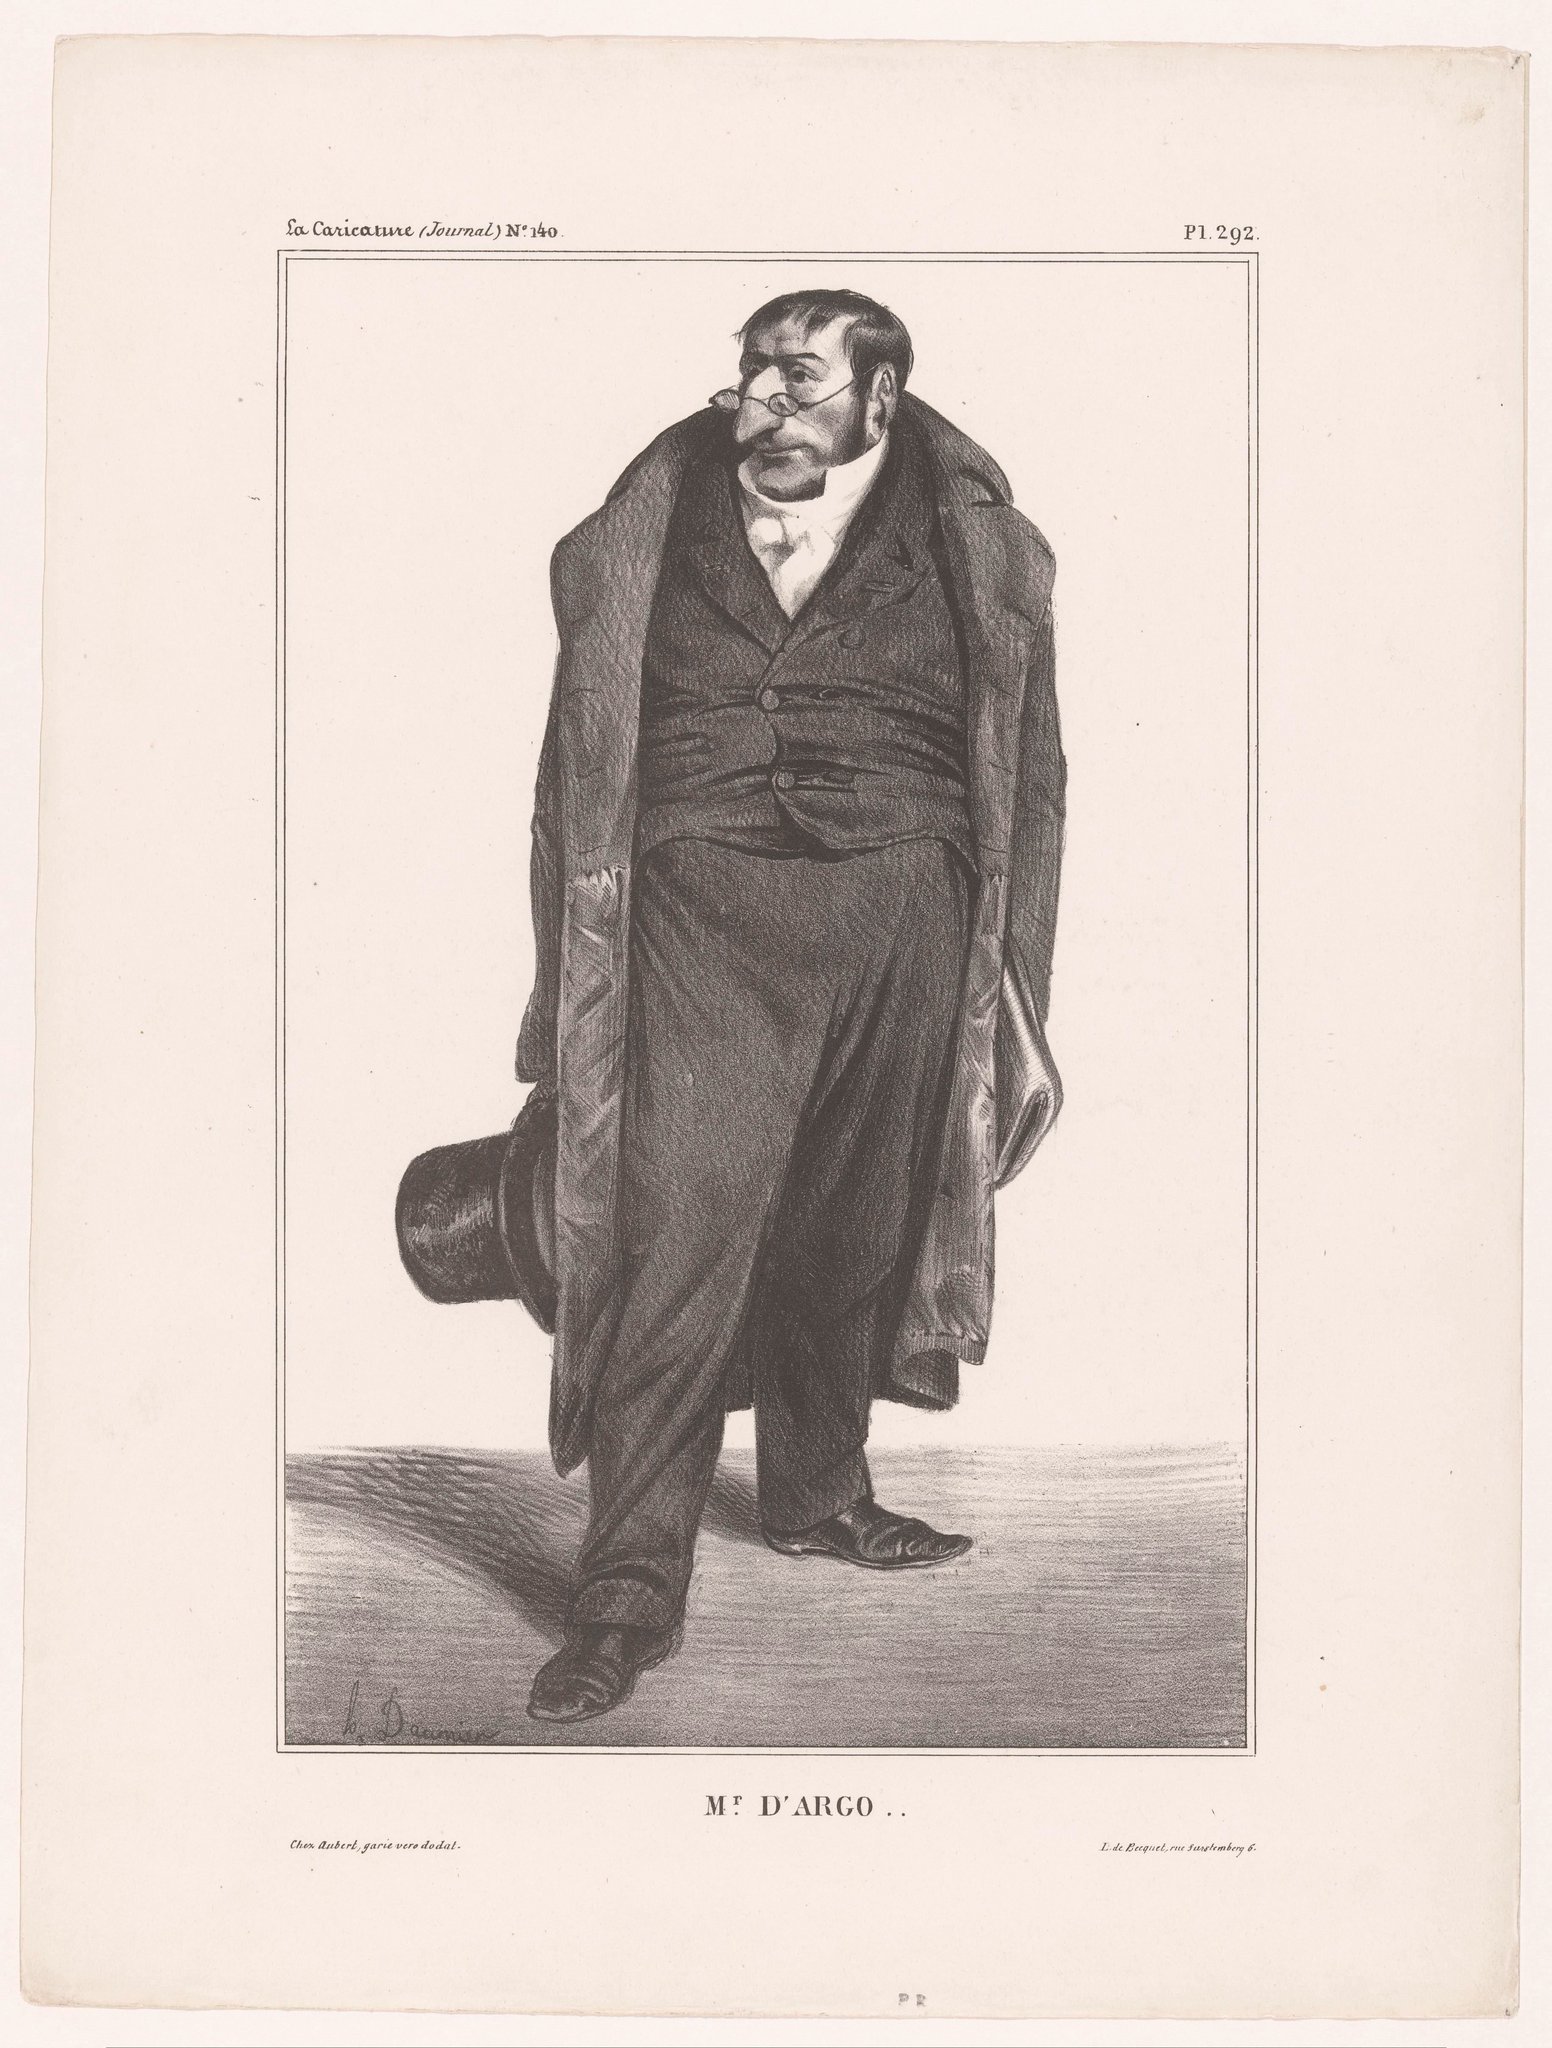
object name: cartoon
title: Karikatuur van minister Antoine Maurice Apollinaire d'Argout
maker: honoré daumier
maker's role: draughtsman, painter, print maker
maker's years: 1808-1879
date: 1833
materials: paper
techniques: lithograph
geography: paris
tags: politician, minister ~ government, caricatures (human types), historical persons, political caricatures and satires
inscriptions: collector's mark: Lugt 2760, collector's mark: Lugt 2228a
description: Prent gepubliceerd in: La Caricature, 11 juli 1833, nr. 140, pl. 292.